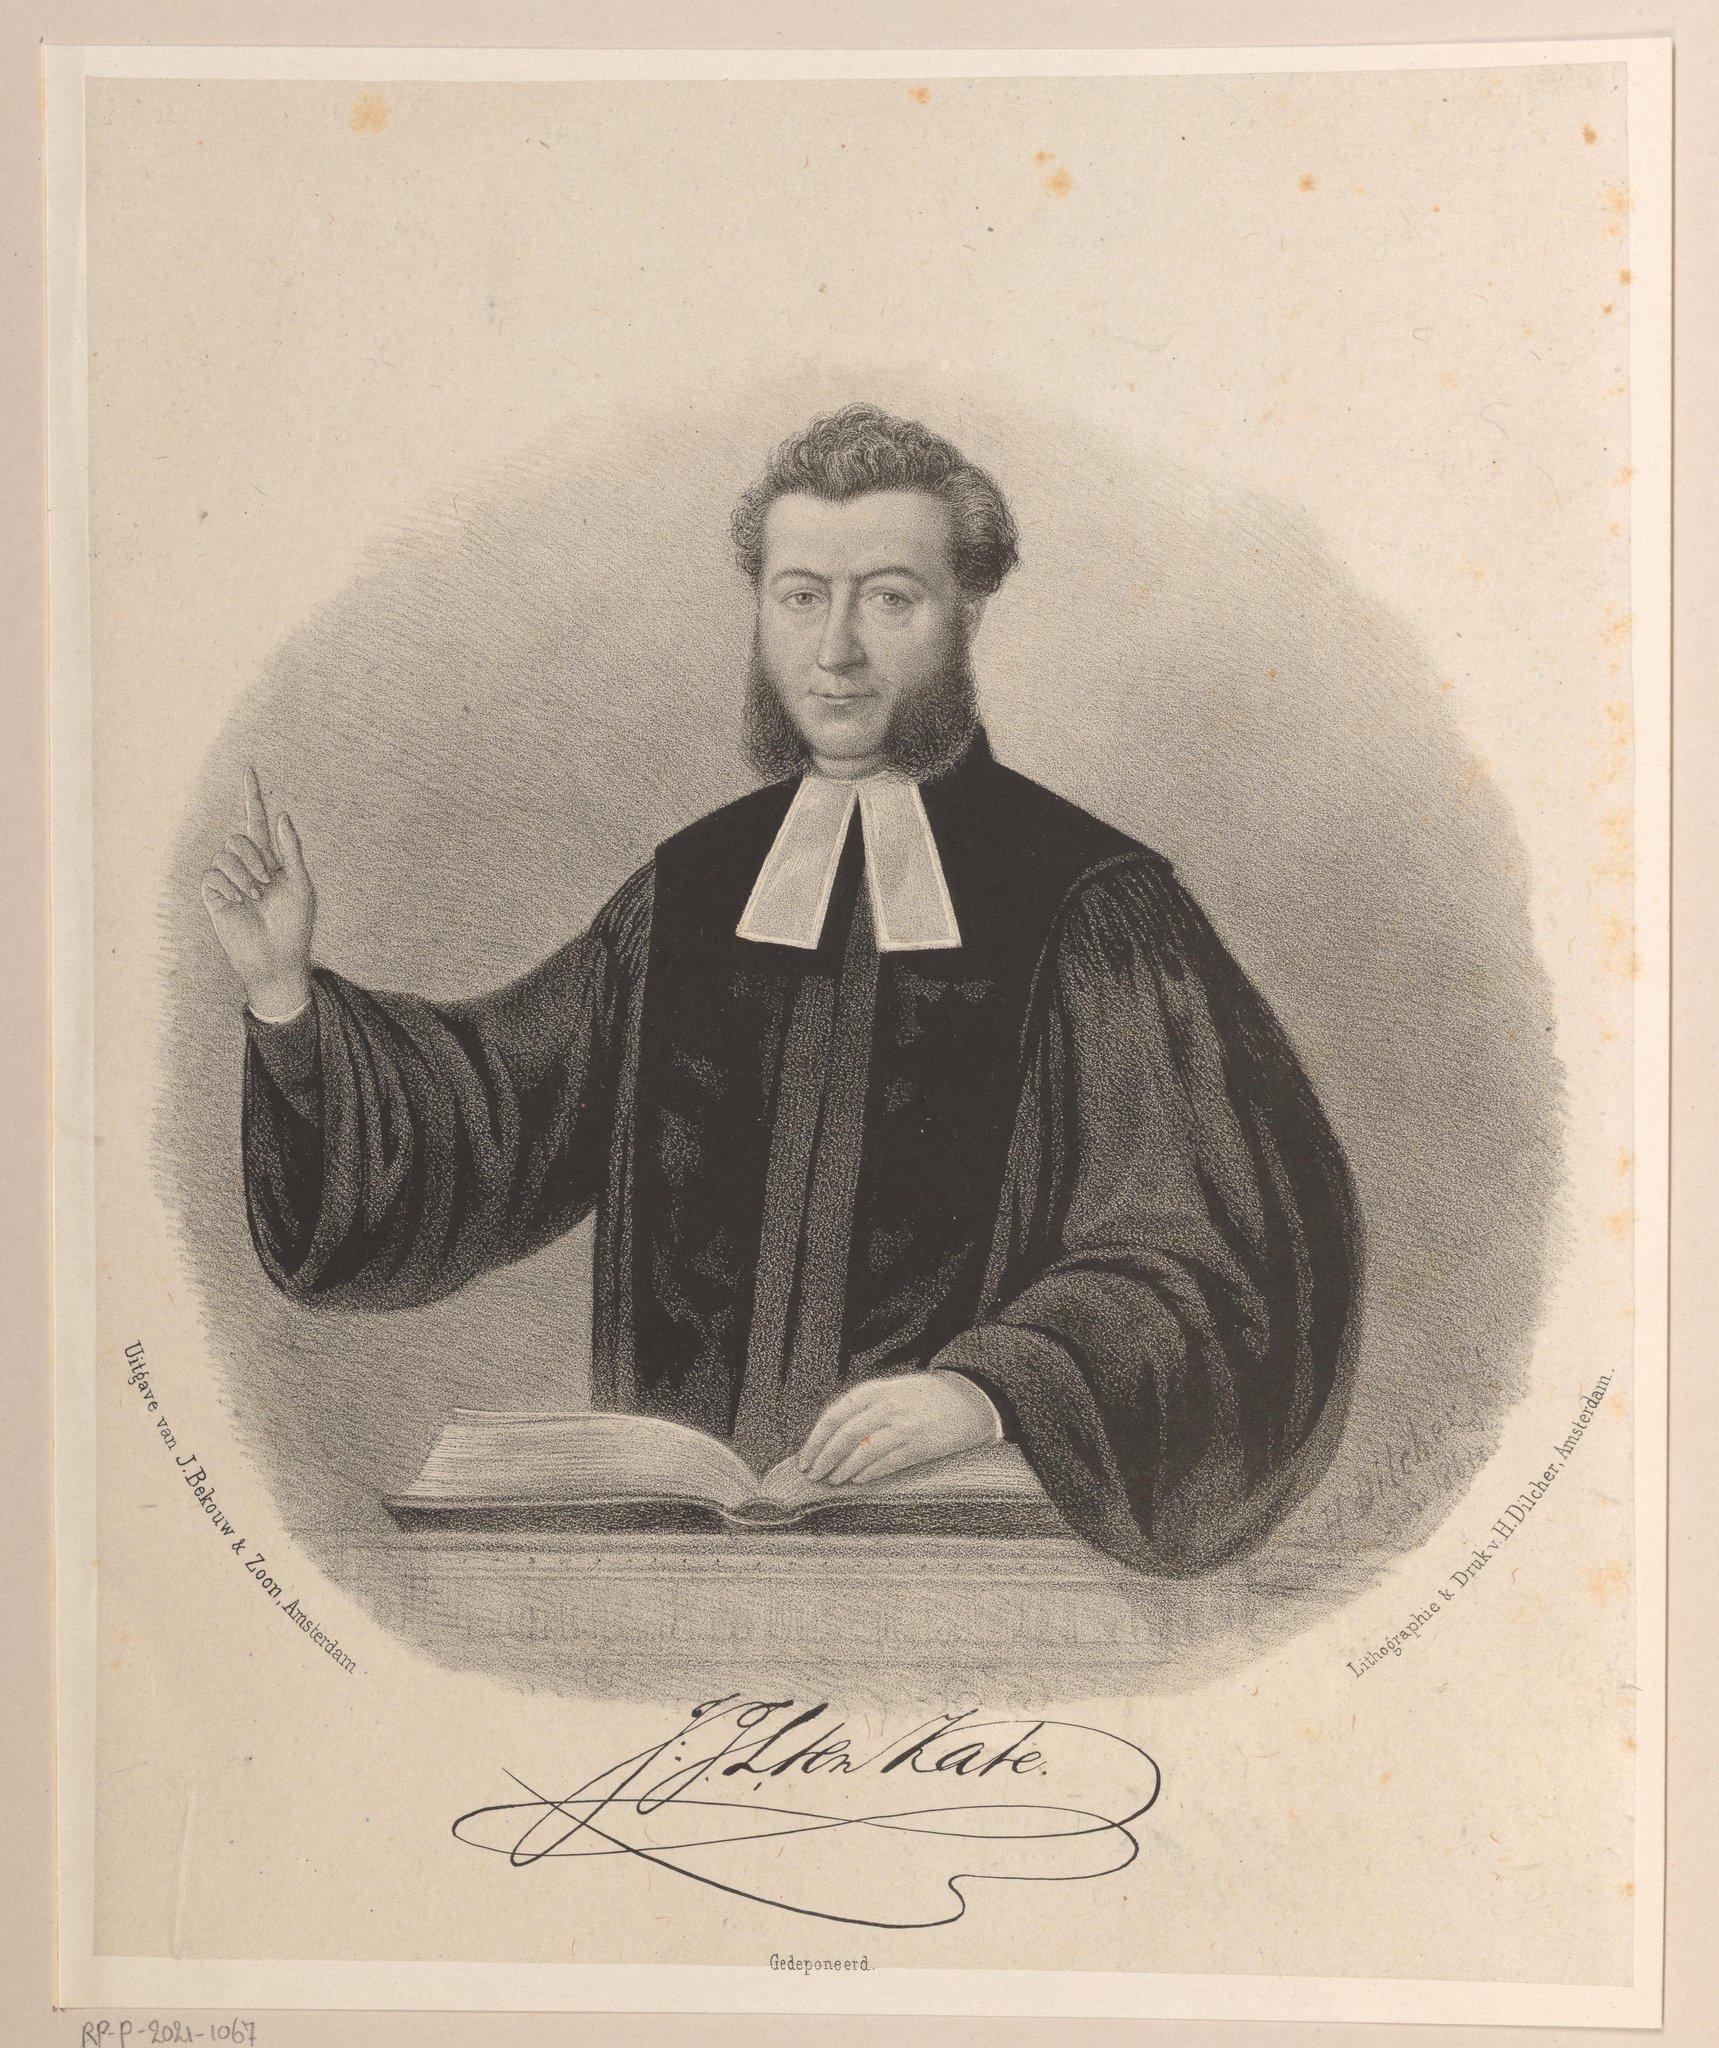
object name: print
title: Portret van Jan Jacob Lodewijk ten Kate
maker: heinrich dilcher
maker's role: print maker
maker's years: 1824-1885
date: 1861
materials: paper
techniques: lithograph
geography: amsterdam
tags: the hague, jan jakob lodewijk ten kate, historical persons, writer, poet, author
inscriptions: date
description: Onder het portret een facsimile van de handtekening van de geportretteerde.